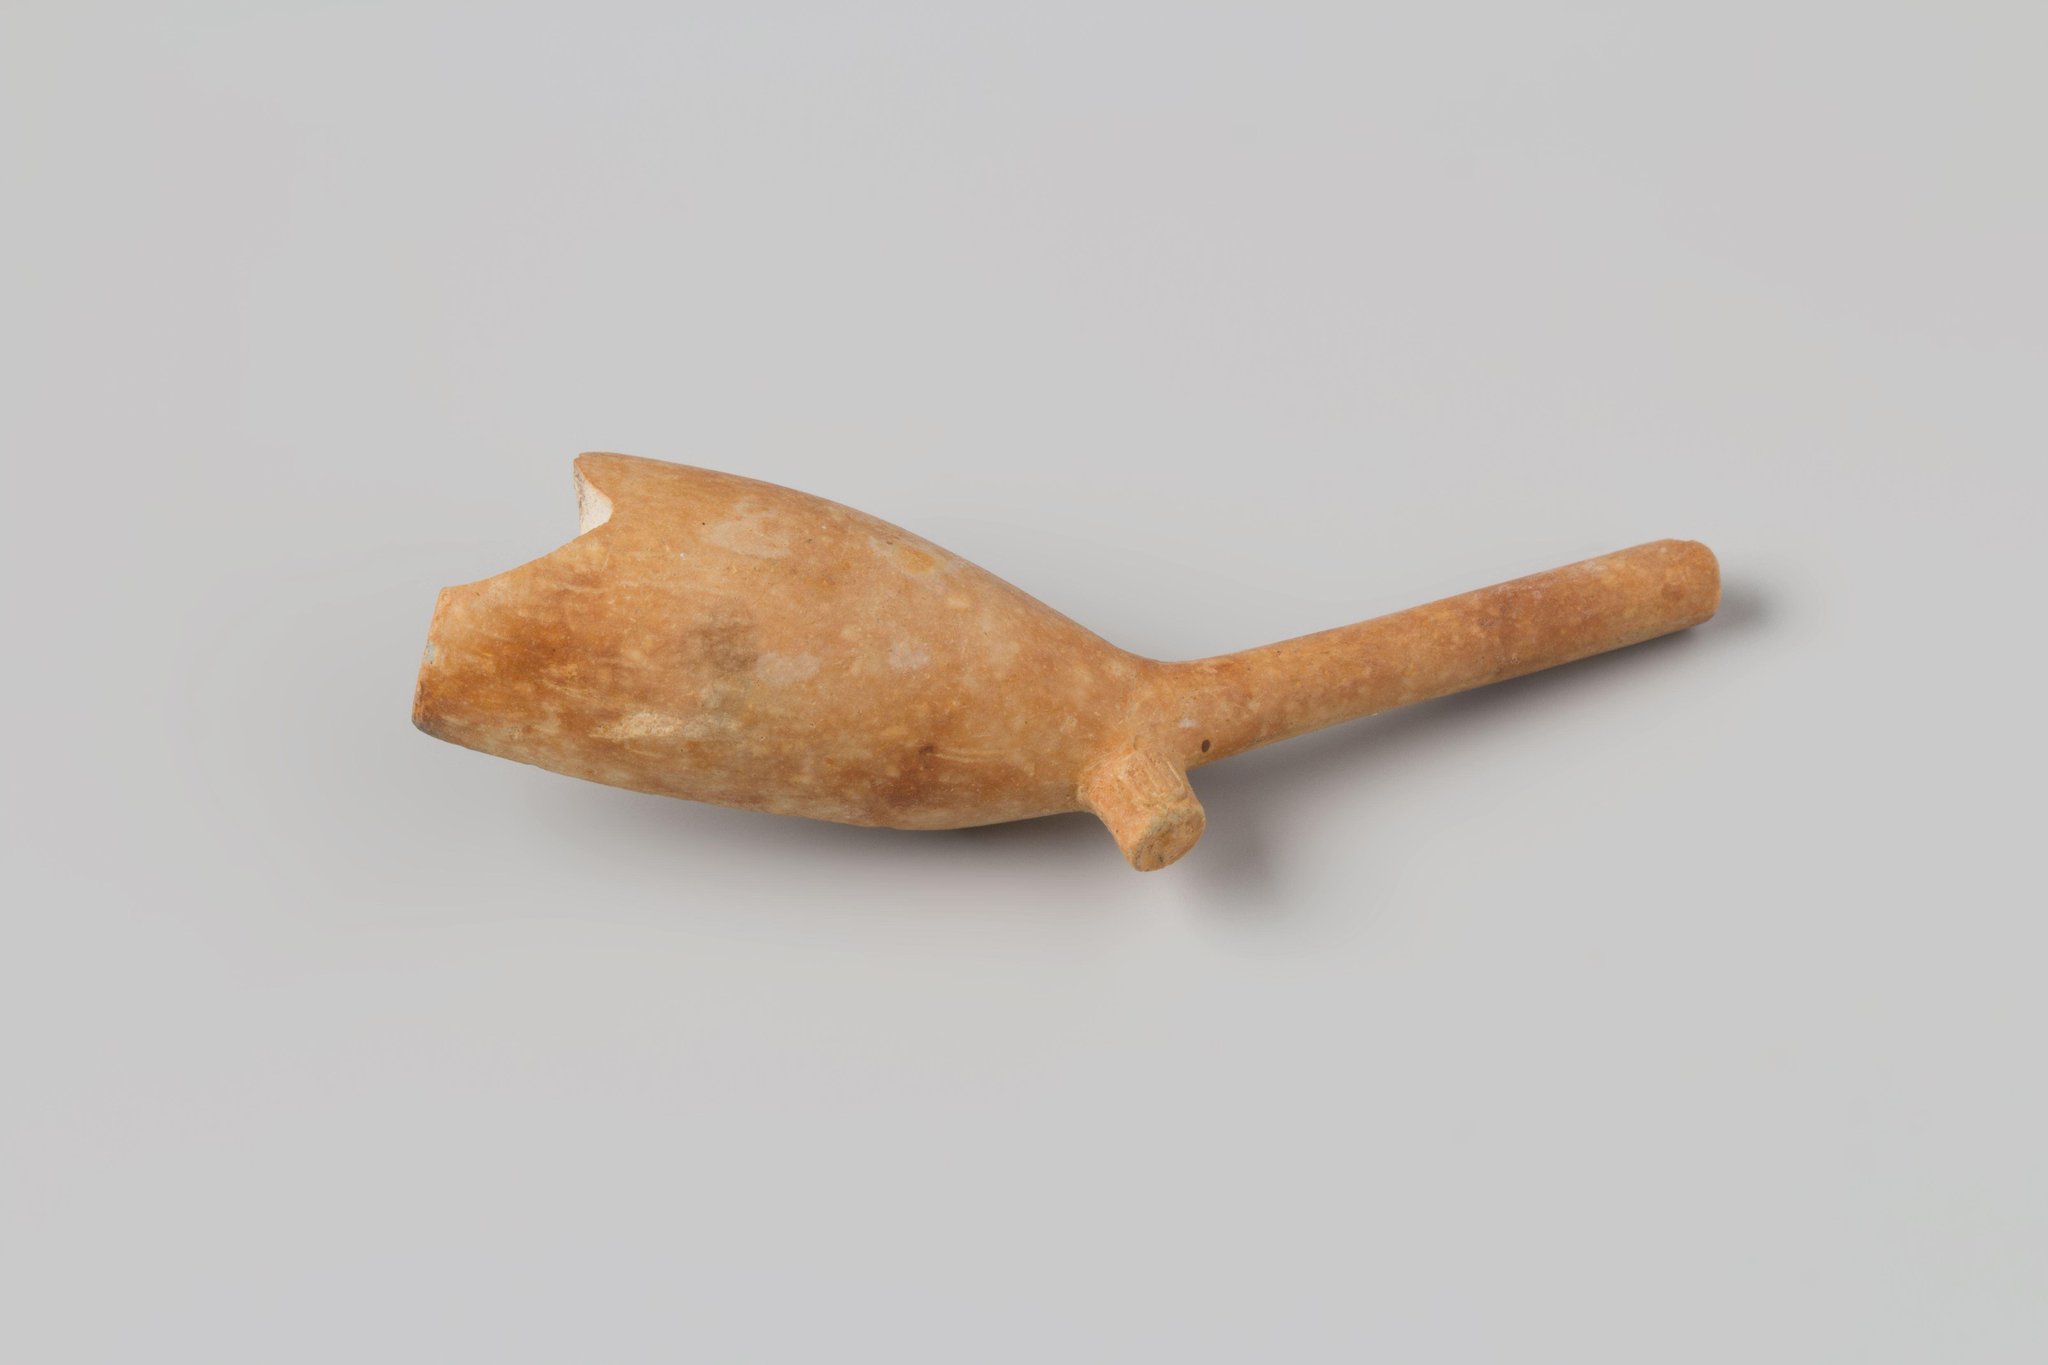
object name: pipe bowl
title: Fragment pijpenkop met stuk steel uit het wrak van de Oost-Indiëvaarder Hollandia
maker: Anonymous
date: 1700-1743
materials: clay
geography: netherlands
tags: verenigde oostindische compagnie, hollandia (schip), annet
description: Pipe, bowl, heelmark: fish, flounder; fragm, 2hsm1,5.